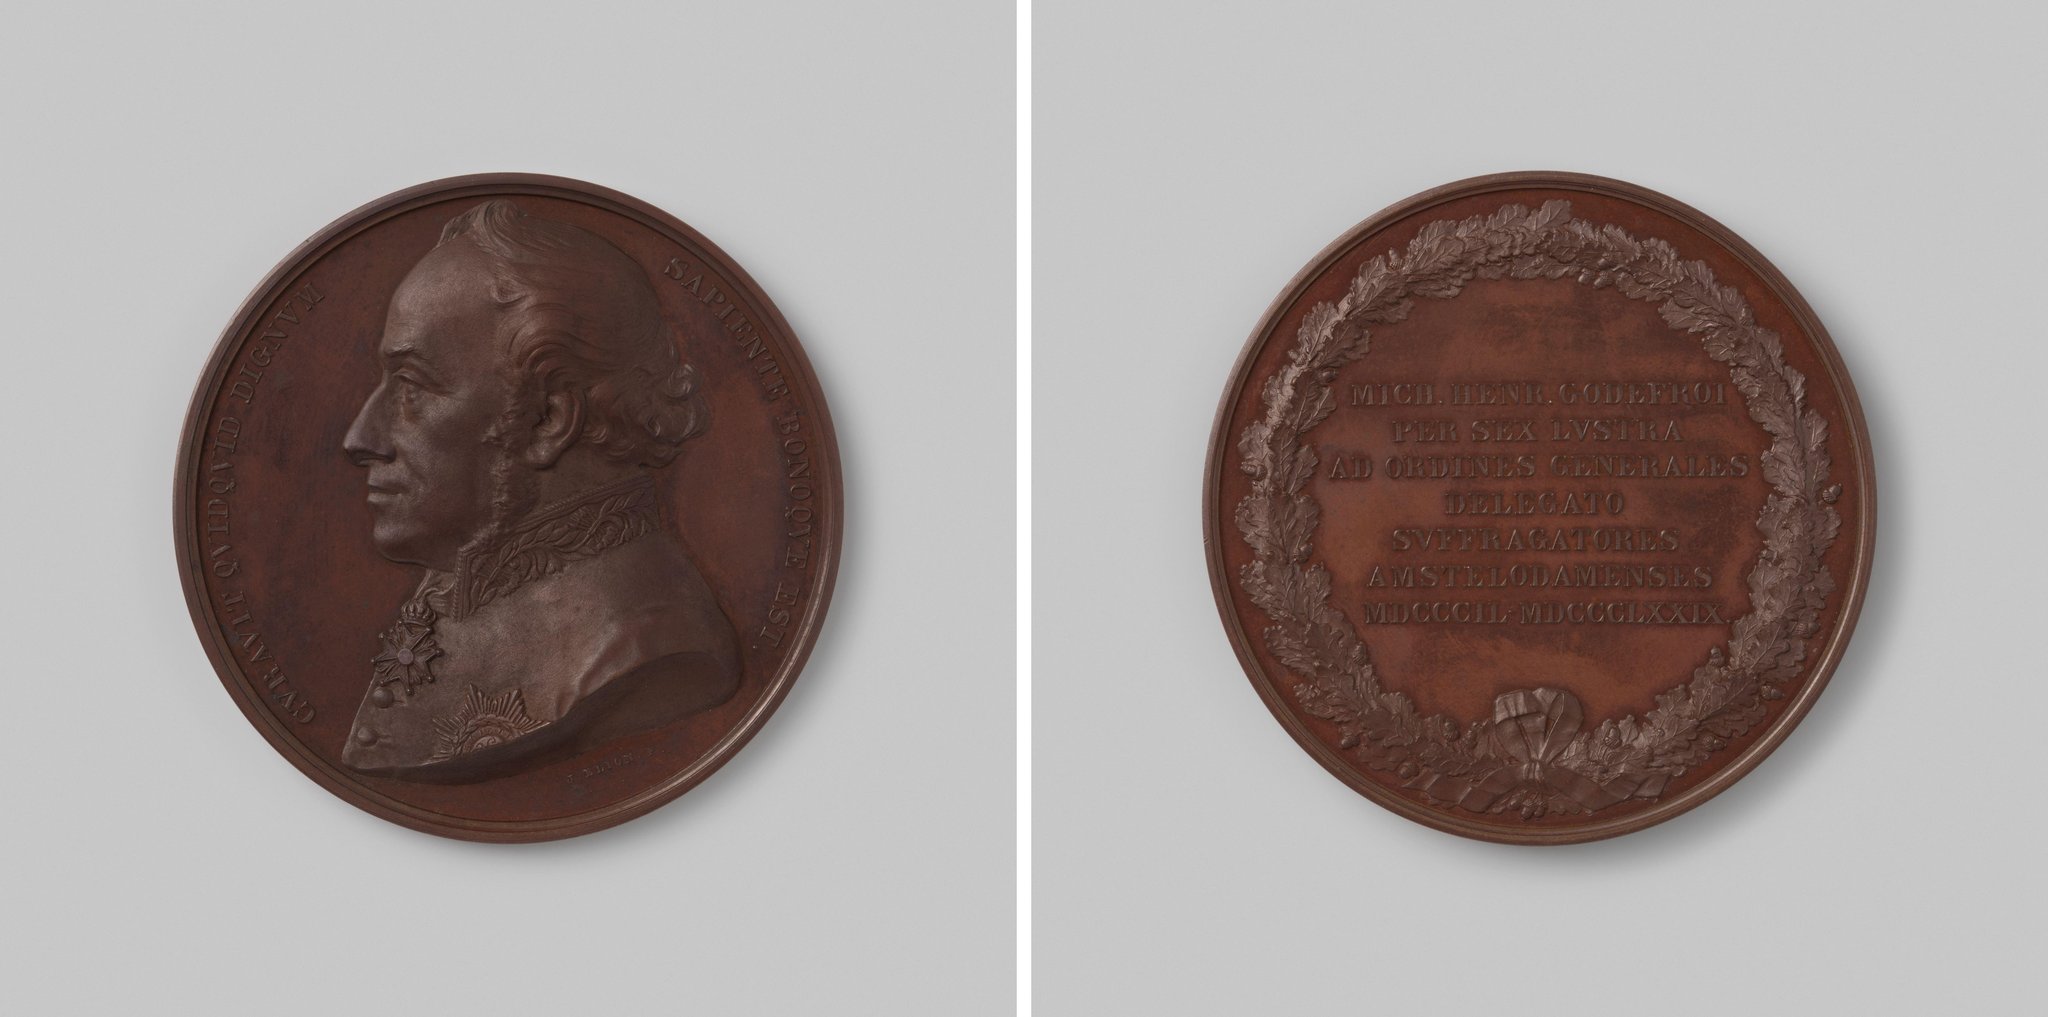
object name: history medal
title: Mich. Henr. Godefroi dertig jaar lid van de Tweede Kamer der Staten-Generaal 1879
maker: jacob samuel cohen elion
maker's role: draughtsman, painter, print maker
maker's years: 1840-1893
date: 1879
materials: bronze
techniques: striking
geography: amsterdam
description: Bronzen penning, op de voorzijde het borstbeeld van Godefroi naar lins met omschrift, op de keerzijde zeven regels tekst tussen samengestrikte eikentakken.